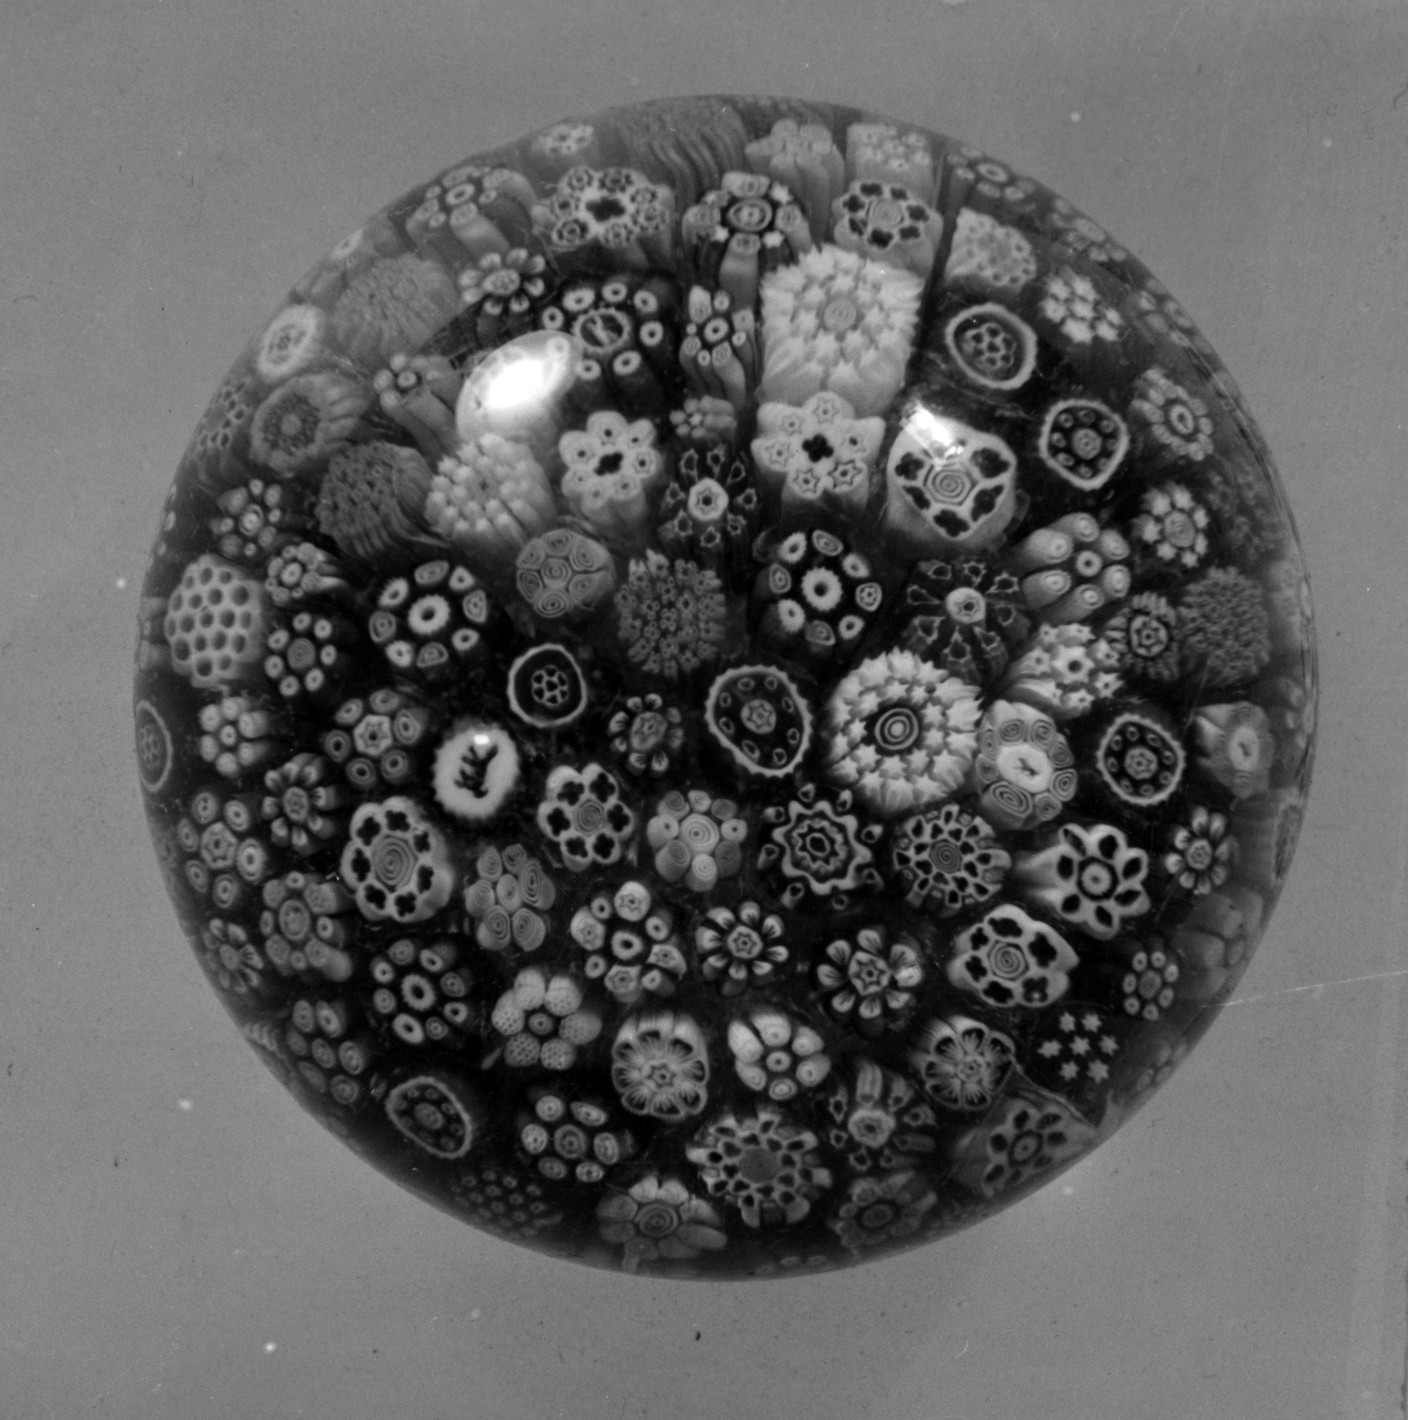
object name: paperweight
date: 1845-1850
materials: glass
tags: flowers